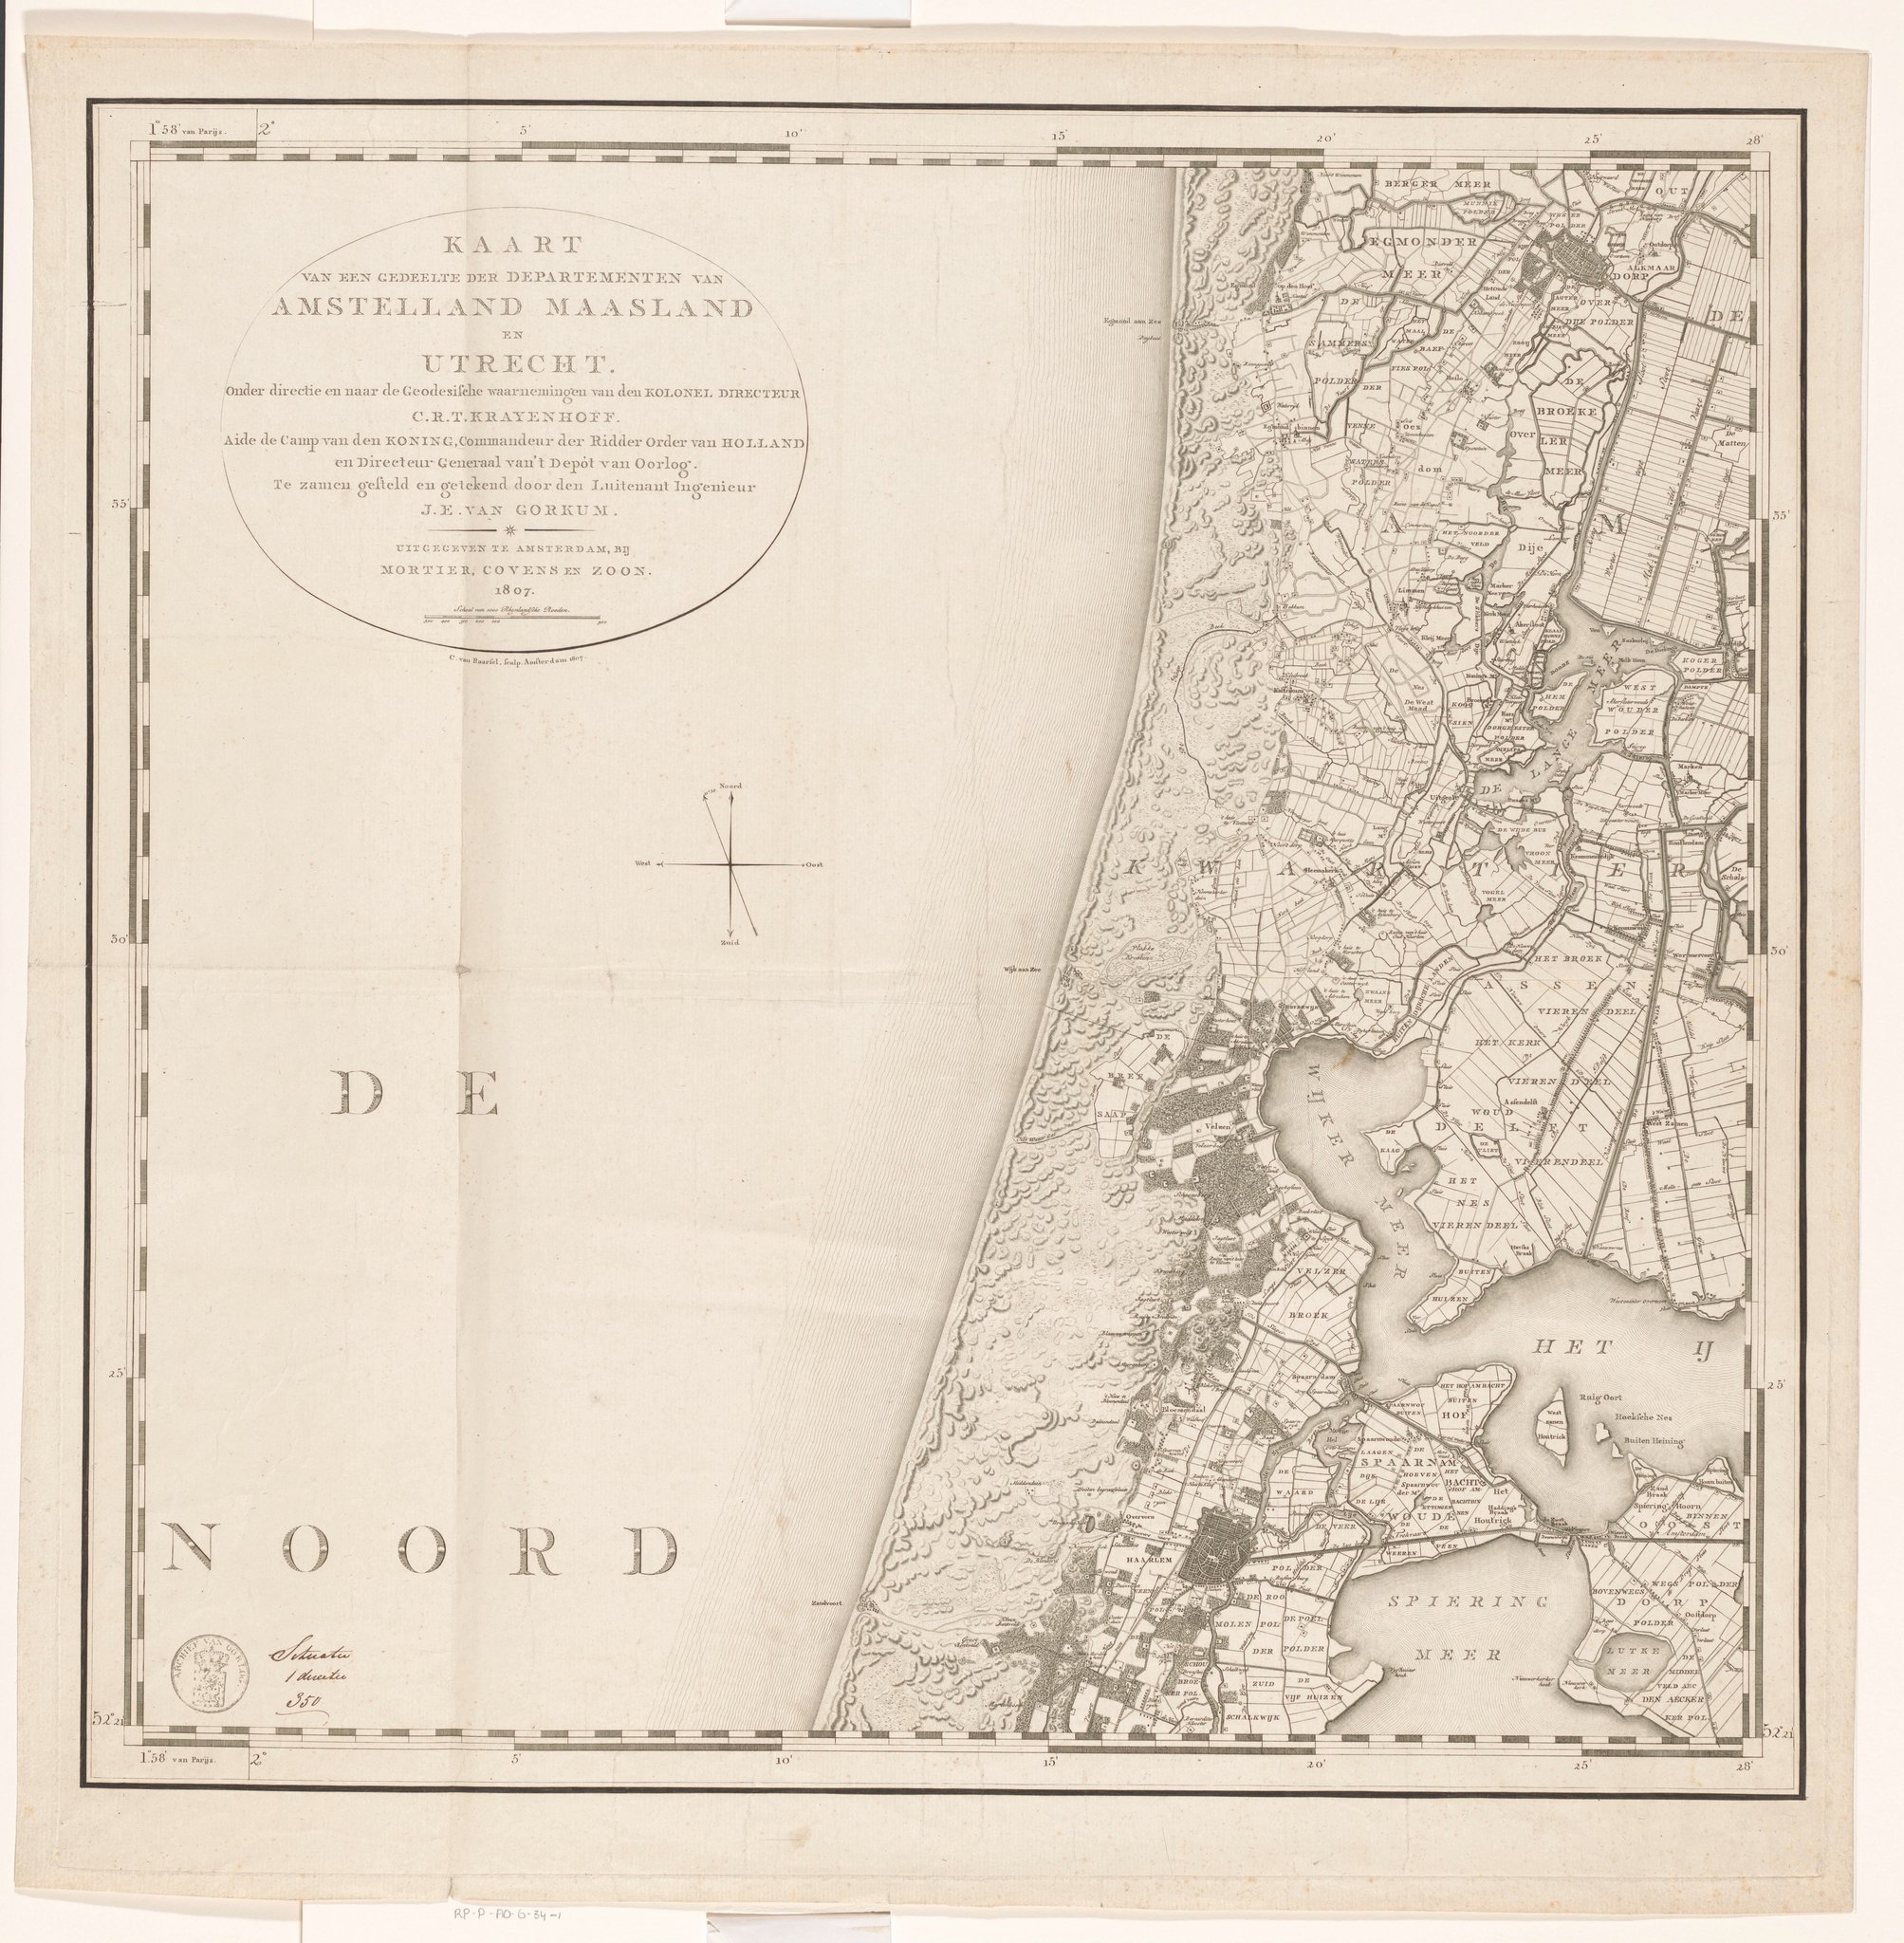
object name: print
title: Deel van een kaart van de departementen Amstelland, Maasland en Utrecht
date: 1807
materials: ink, paper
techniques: engraving, pen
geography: amsterdam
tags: maps of separate countries or regions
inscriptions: inscription: ‘Situatie 1 directie 350’, collector's mark: Lugt 19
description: Linksboven de titel en een schaalstok: Schaal van 100 Rhynlandsche roeden. Gradenverdeling langs de randen. Dit is een deel van een kaart van de departementen Amstelland, Maasland en Utrecht. De bedoeling was dat deze kaart in vier delen zou verschijnen, zoals aangegeven op het inhoudsblad (RP-P-AO-6-34-2), maar uiteindelijk verschenen alleen de twee bovenste bladen. De huidige kaart is het linkerblad.